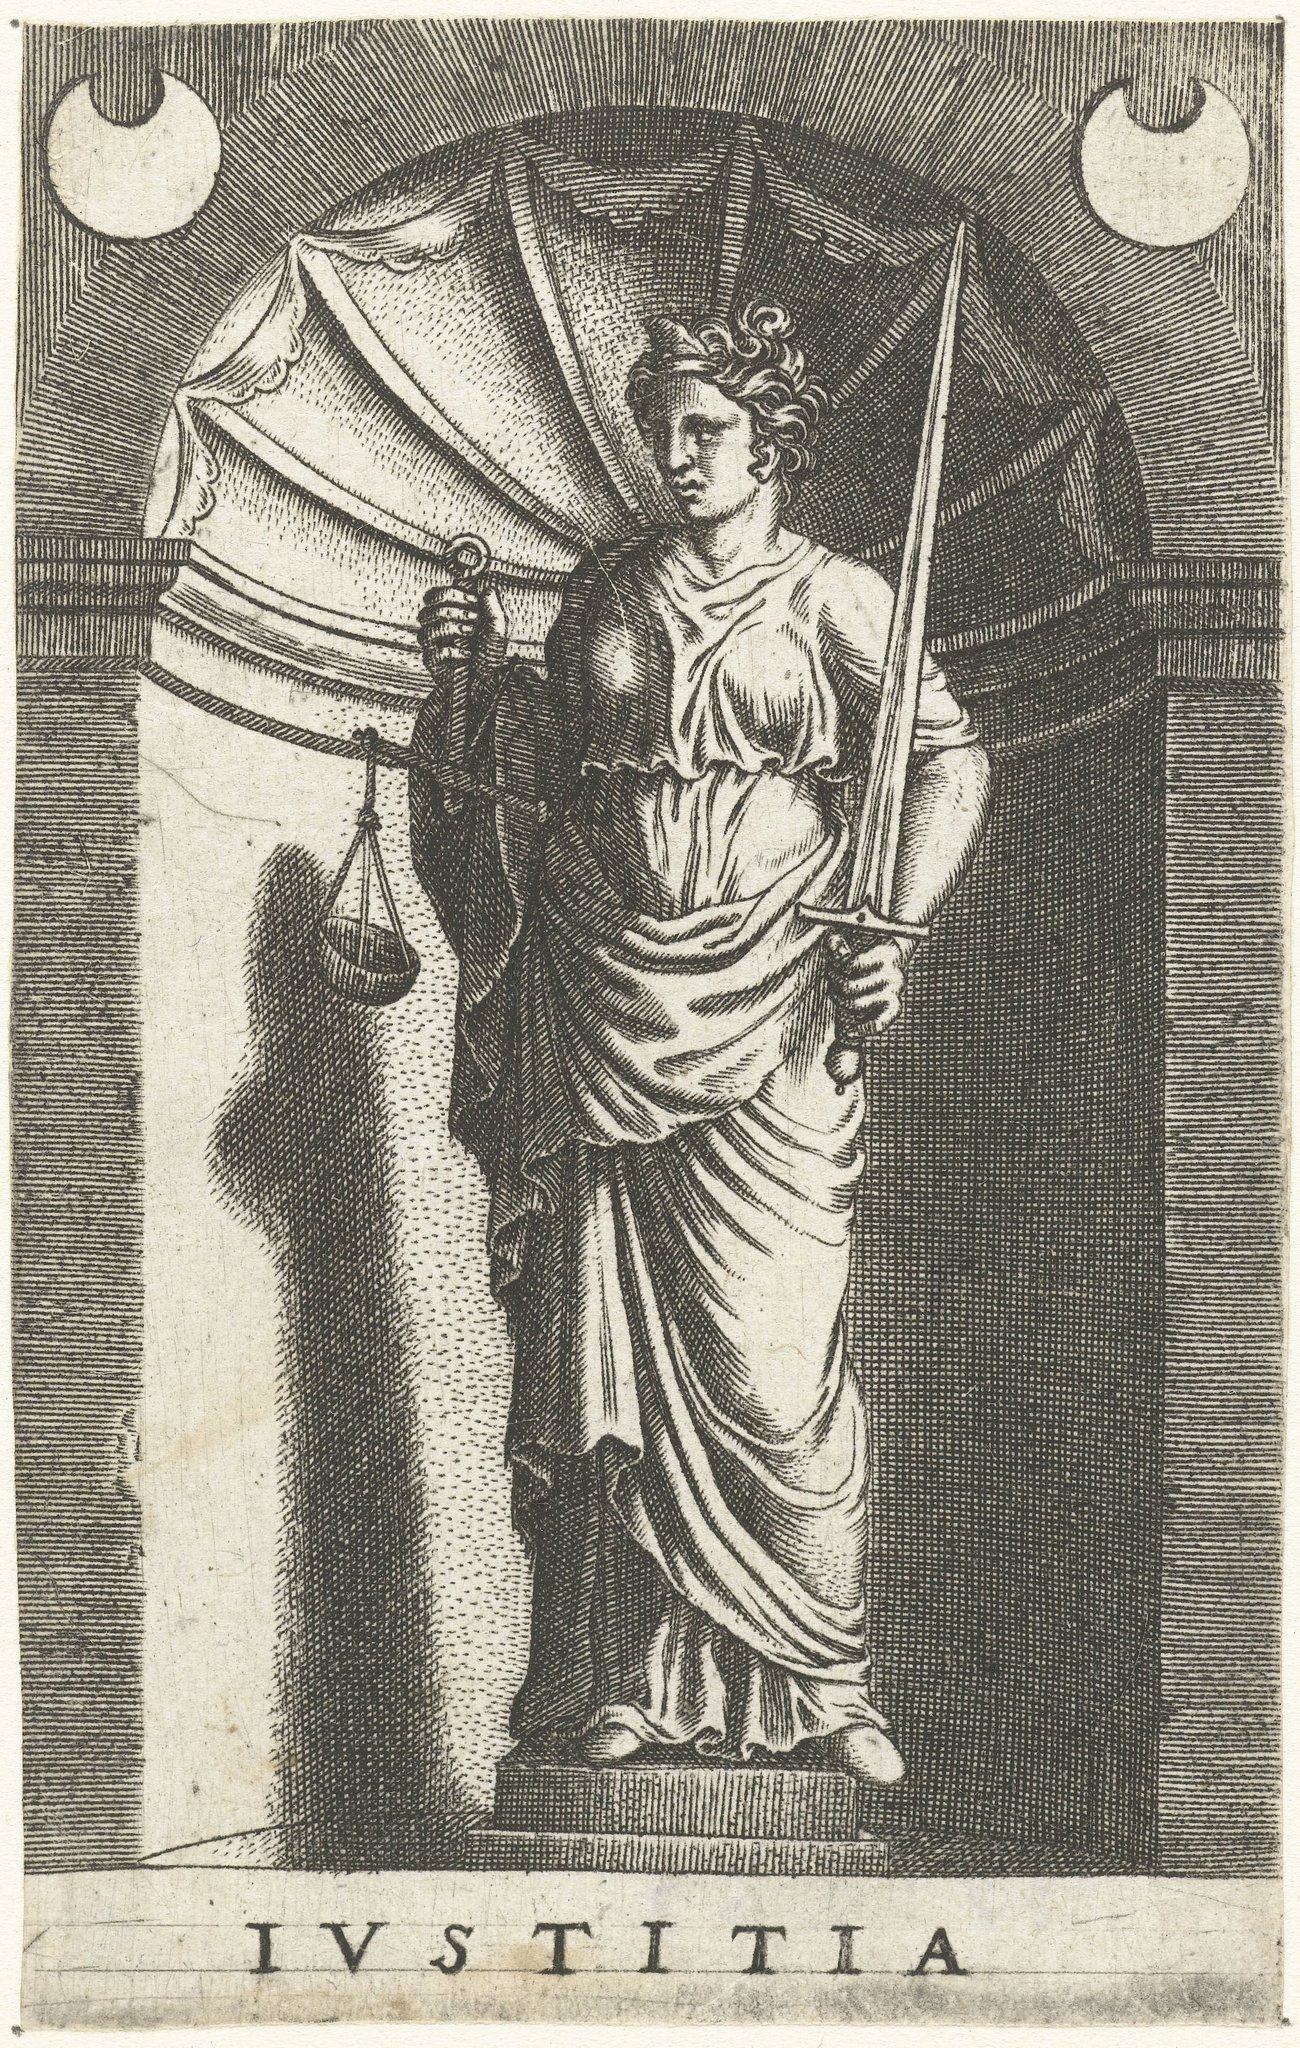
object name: print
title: De zeven deugden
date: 1557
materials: paper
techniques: engraving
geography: antwerp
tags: justice, 'justitia'; 'giustitia divina' (ripa) ~ one of the four cardinal virtues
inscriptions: collector's mark: Lugt 2228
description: In een nis de vrouwelijke personificatie van Rechtvaardigheid (Justitia), een van de vier kardinale deugden. In haar handen het zwaard en de weegschaal, respectievelijk het symbool van macht en onpartijdigheid. De prent maakt deel uit van een serie met de zeven deugden als onderwerp.